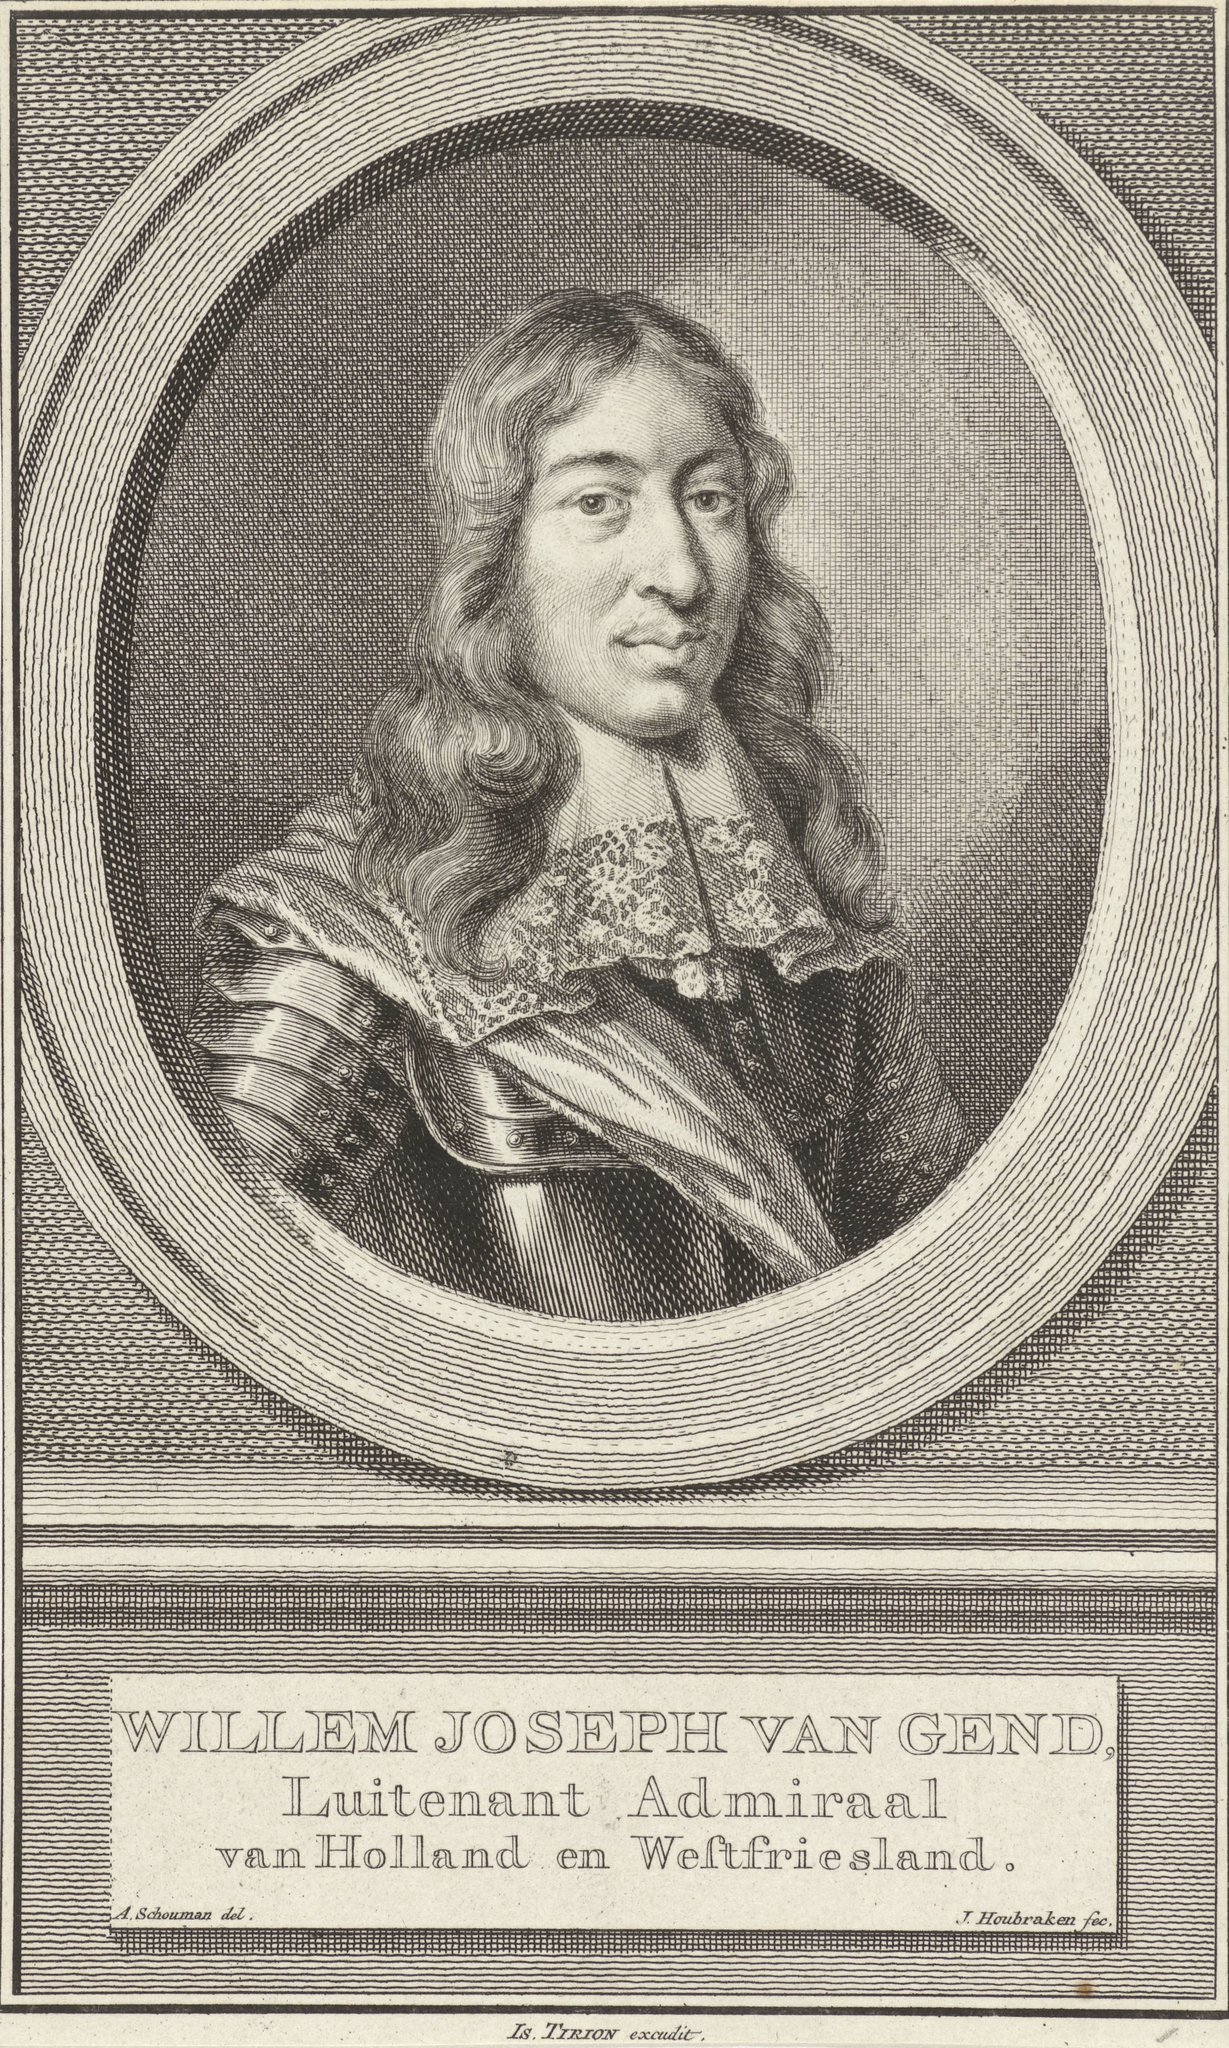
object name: print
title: Portret van Willem Joseph baron van Gendt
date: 1749-1759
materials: paper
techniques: engraving, etching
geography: amsterdam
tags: willem joseph baron van gendt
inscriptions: collector's mark: Lugt 2228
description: Prent ook gebruikt in: Jan Wagenaar, Vaderlandsche historie, vervattende de geschiedenissen der nu Vereenigde Nederlanden, inzonderheid die van Holland (...), 21 delen. Amsterdam, Isaak Tirion, 1749-59.